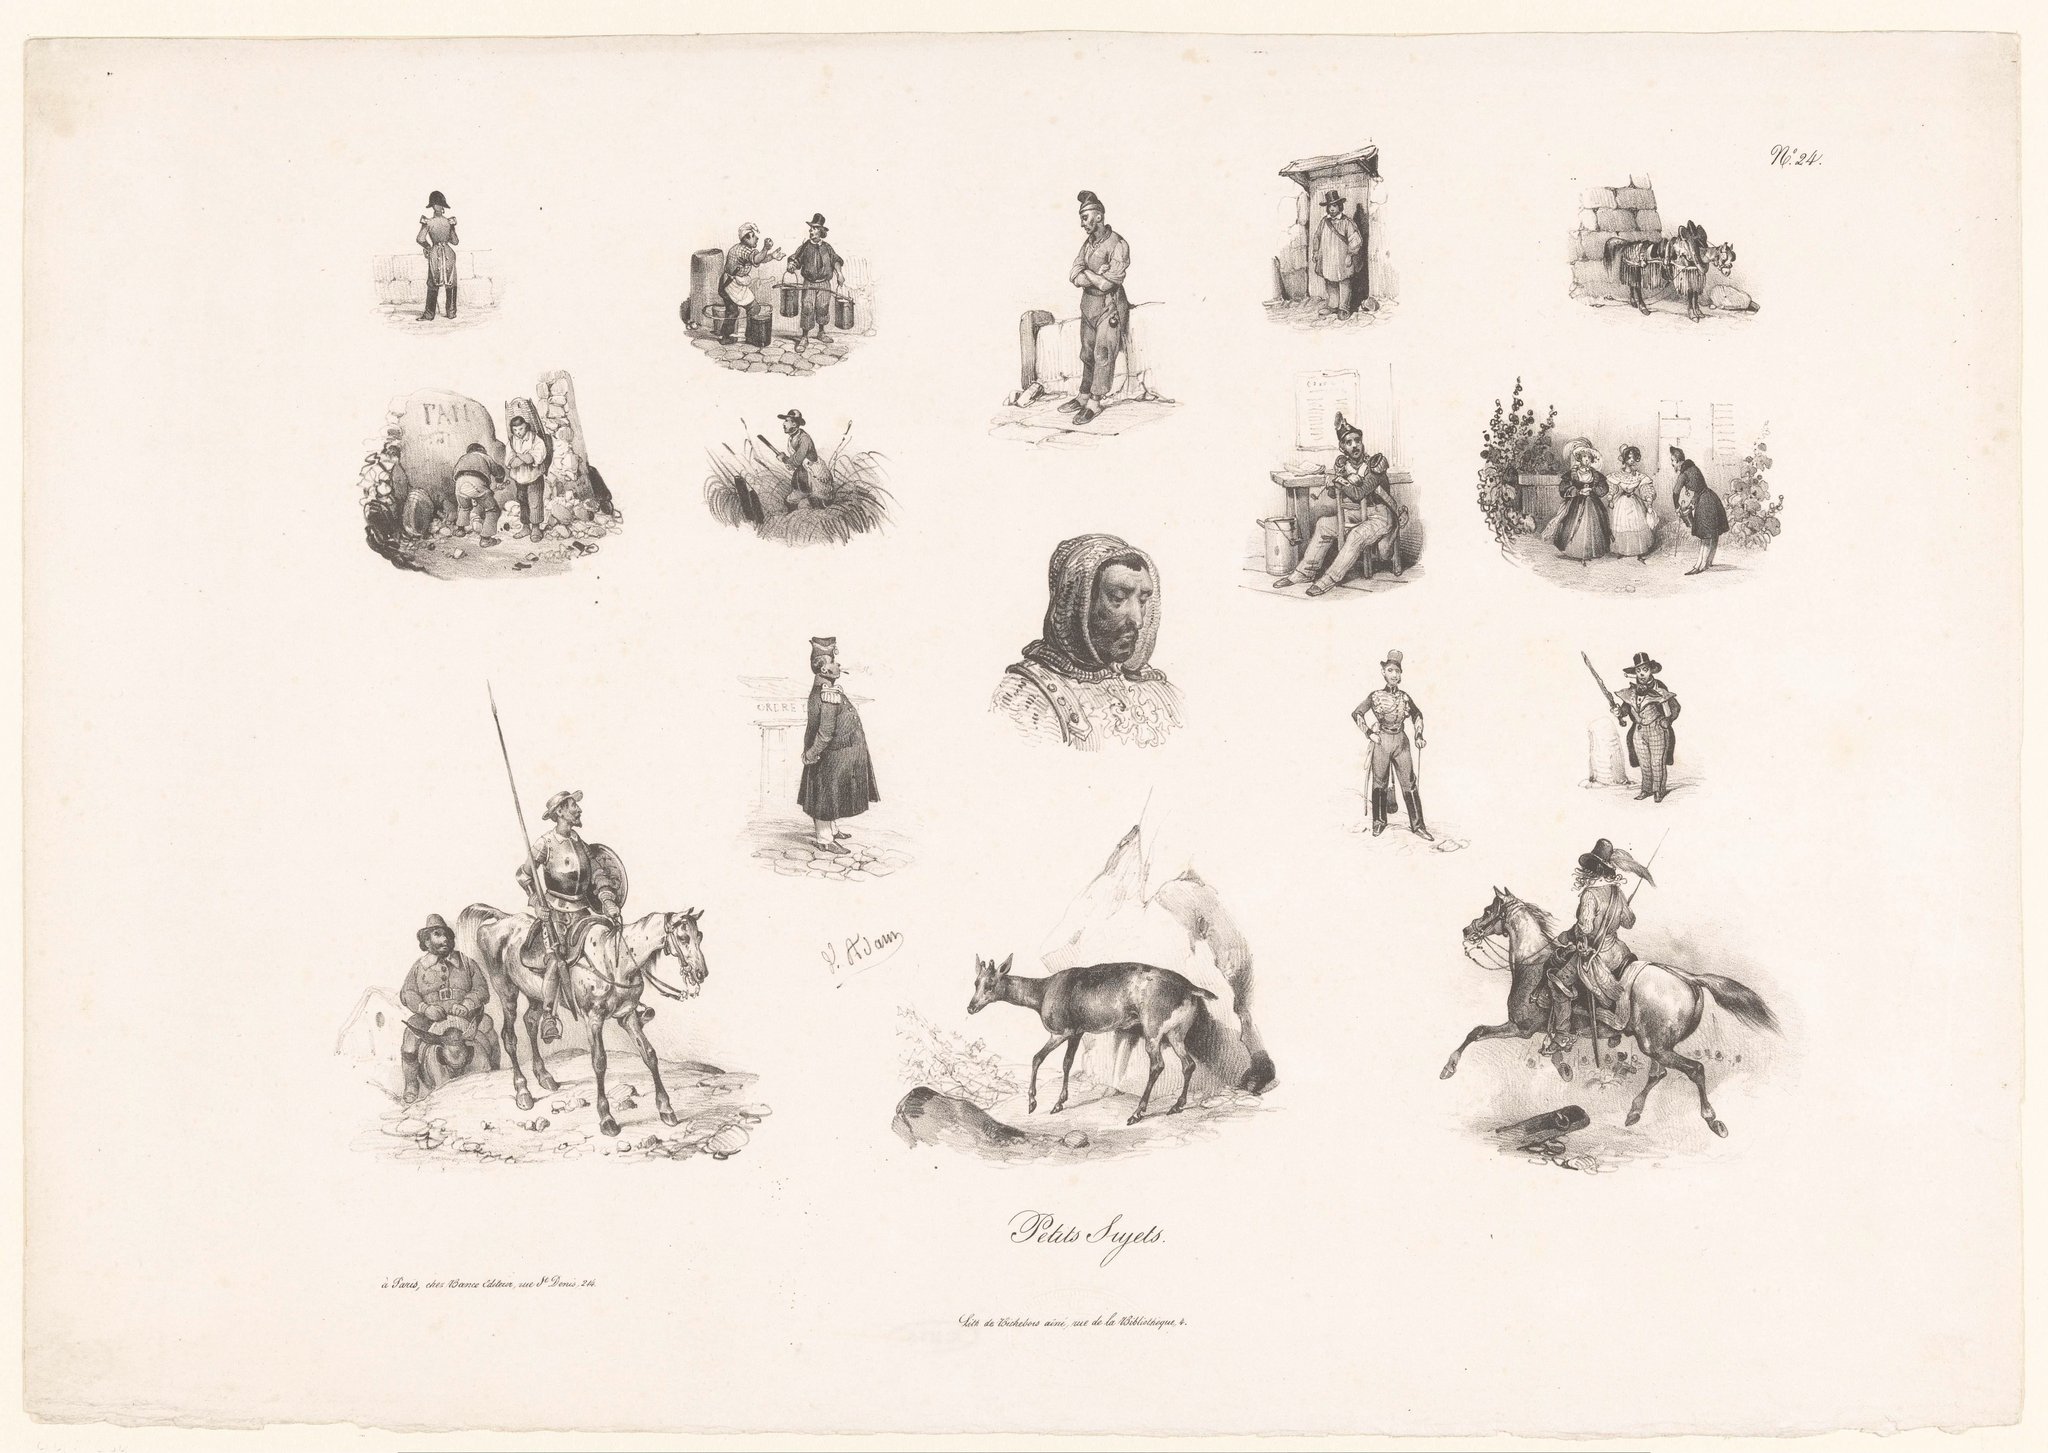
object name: print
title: Petits Sujets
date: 1841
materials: paper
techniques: lithograph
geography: paris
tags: riding a horse, ass, or mule; rider, horseman, hoofed animals: deer, hunter, quarry, the soldier; the soldier's life, horse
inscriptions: check stamp: Lugt 3462, collector's mark: Lugt 2228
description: Een edelman te paard, een hert, een jager, een soldaat, twee mannen in een steengroeve, een heer met twee dames, etc.